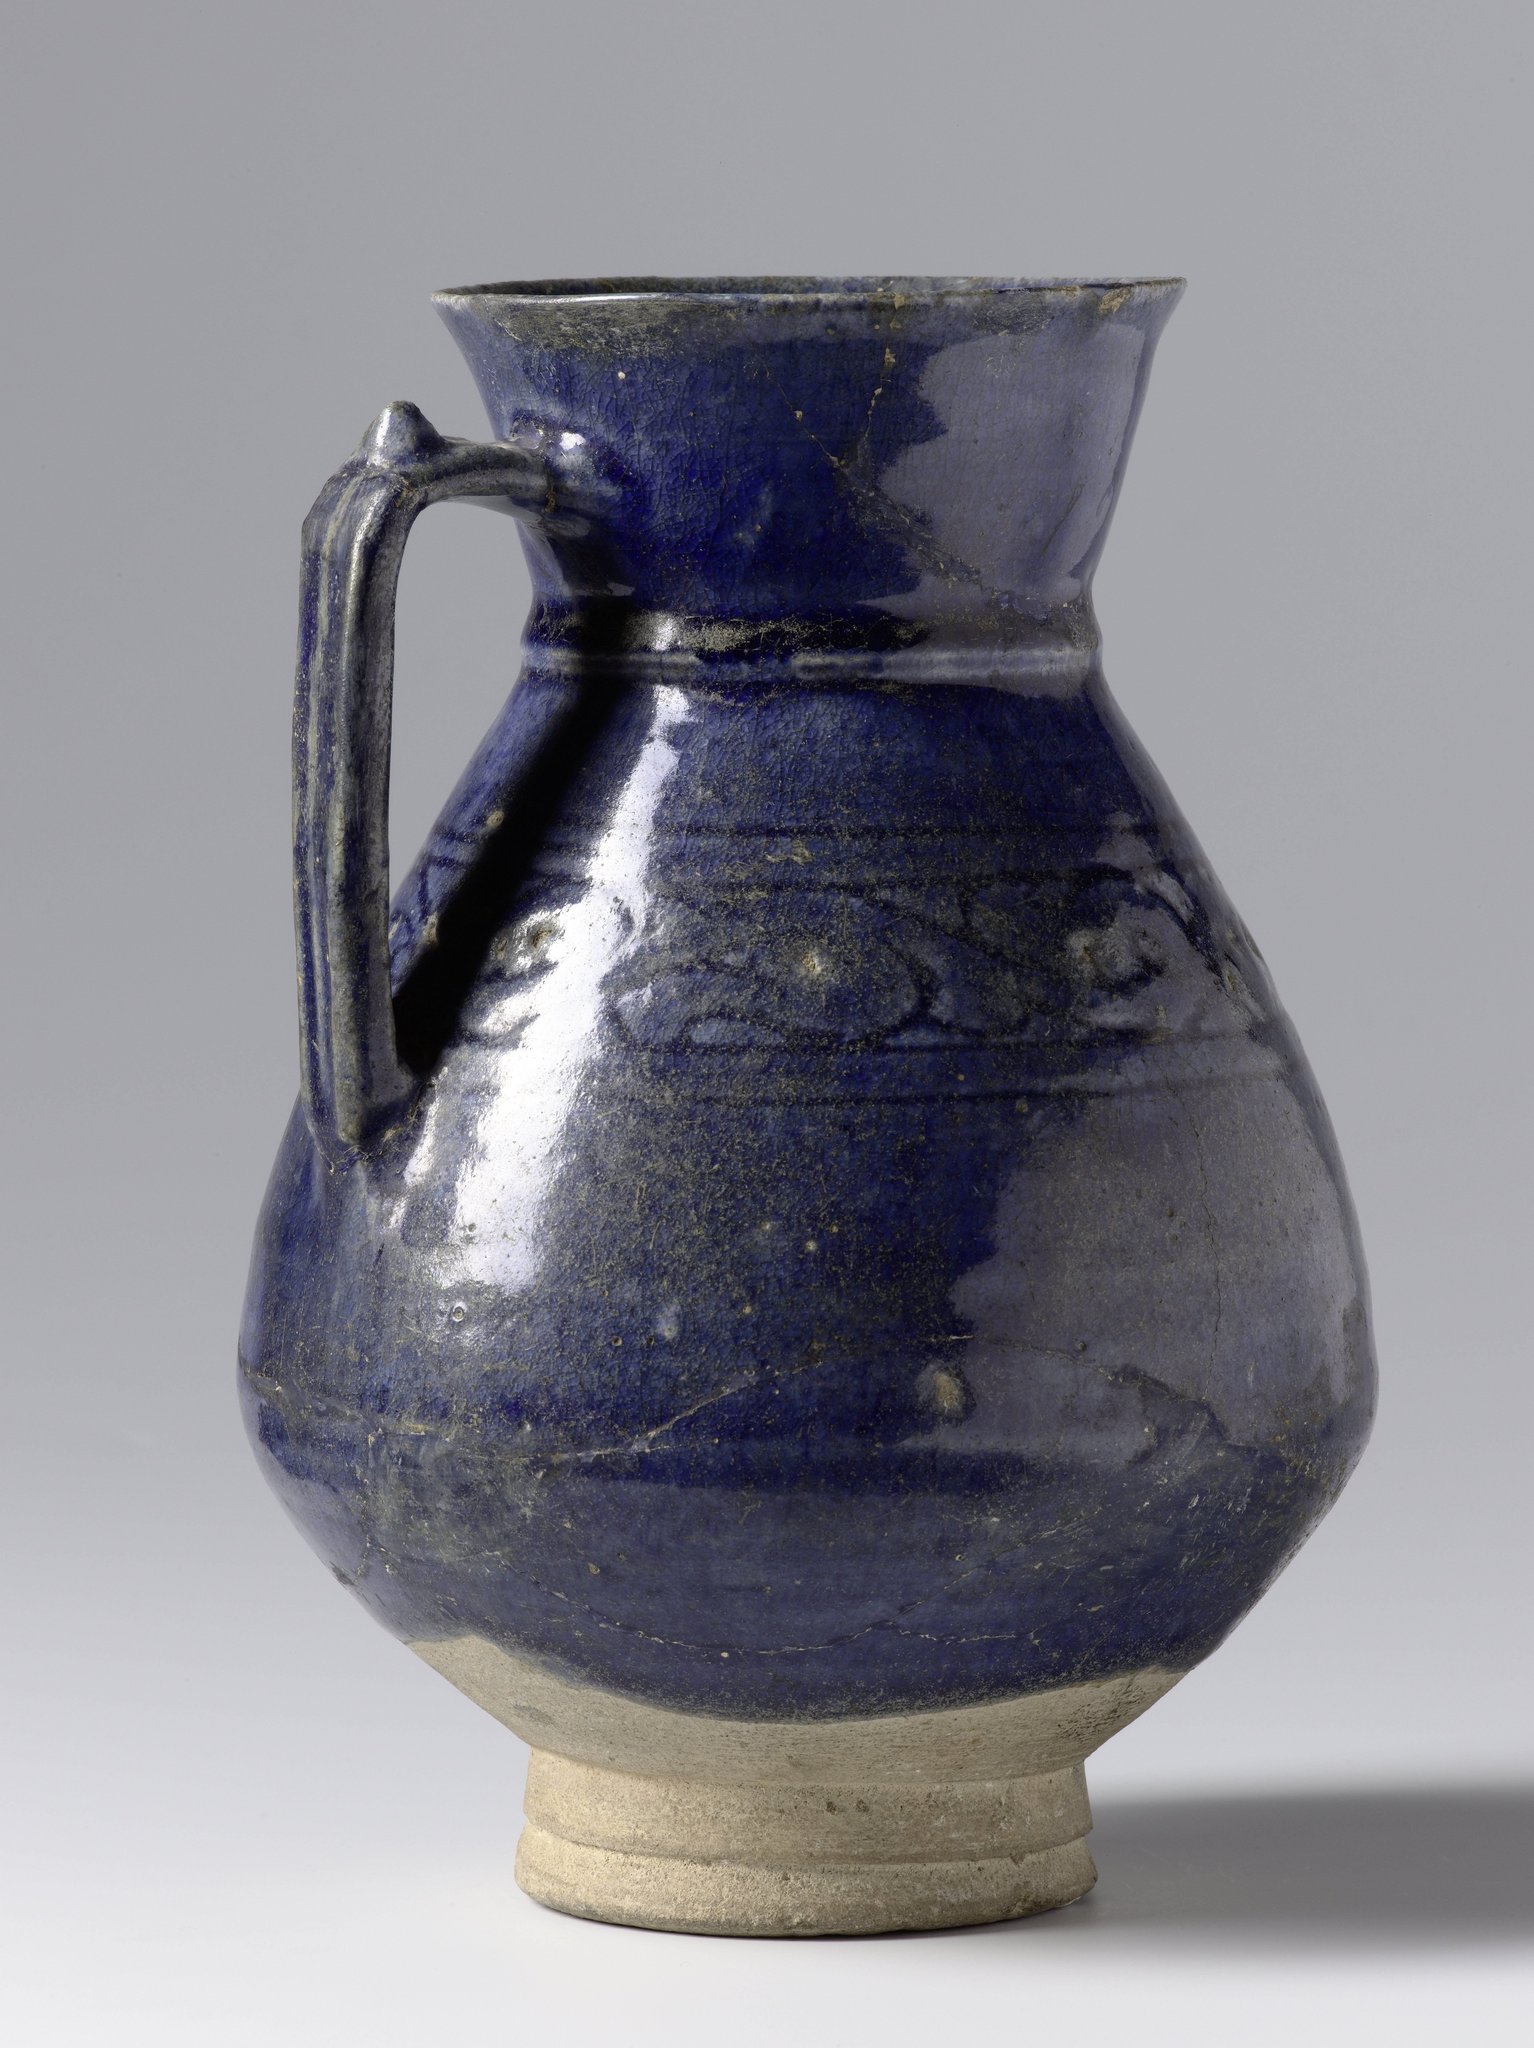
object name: ewer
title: Pear-shaped ewer with a scroll border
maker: Anonymous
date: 1100-1299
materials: earthenware, glaze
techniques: engraving, firing, turning, vitrification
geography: iran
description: Kan van aardewerk gedecoreerd met op de schouder een ingegrifte band met ranken en bedekt met monochroom blauw alkaliglazuur.